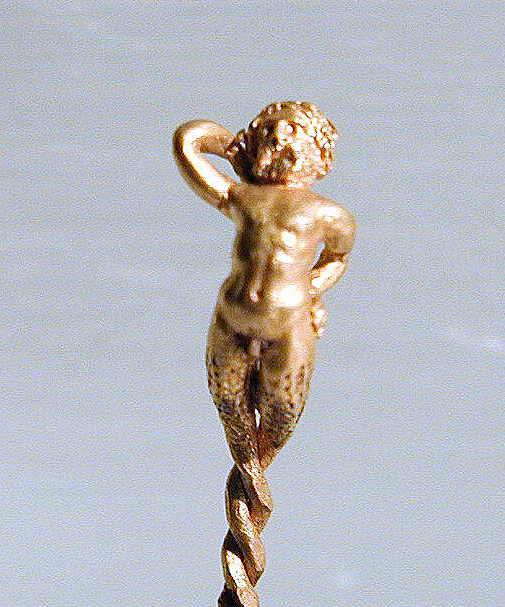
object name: earring in the form of a bearded satyr or triton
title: Gold earring in the form of a bearded satyr or triton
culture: greek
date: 300-101 BCE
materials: gold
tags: satyrs